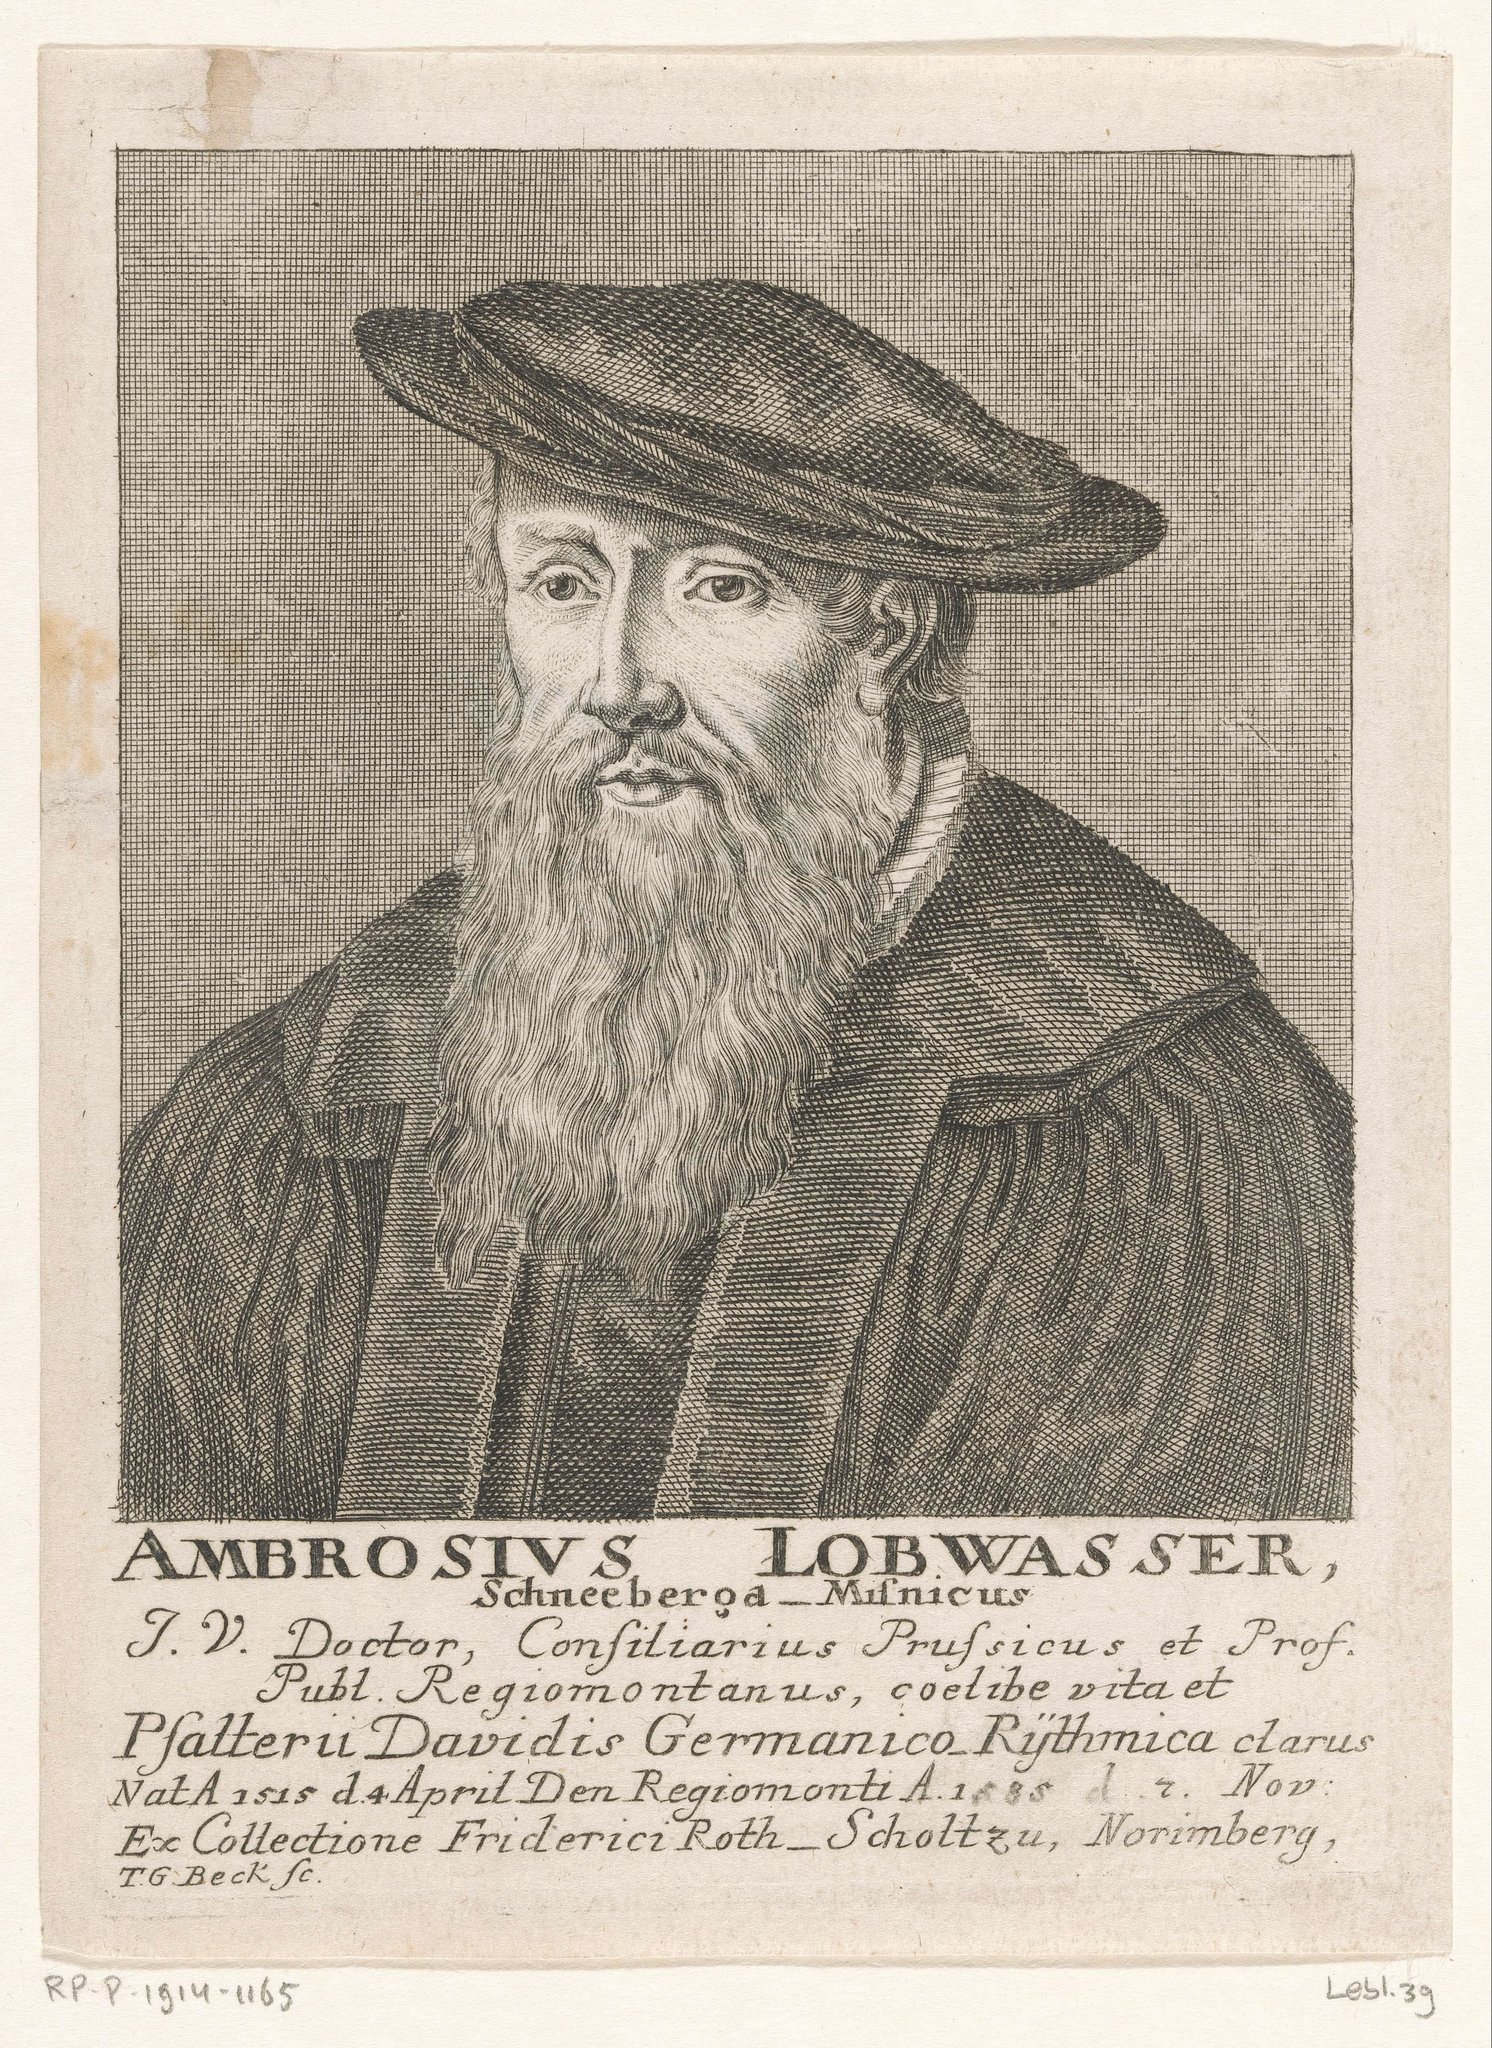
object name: print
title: Portret van Ambrosius Lobwasser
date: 1695-1755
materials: paper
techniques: engraving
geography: nuremberg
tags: historical persons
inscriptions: collector's mark: Lugt 2228